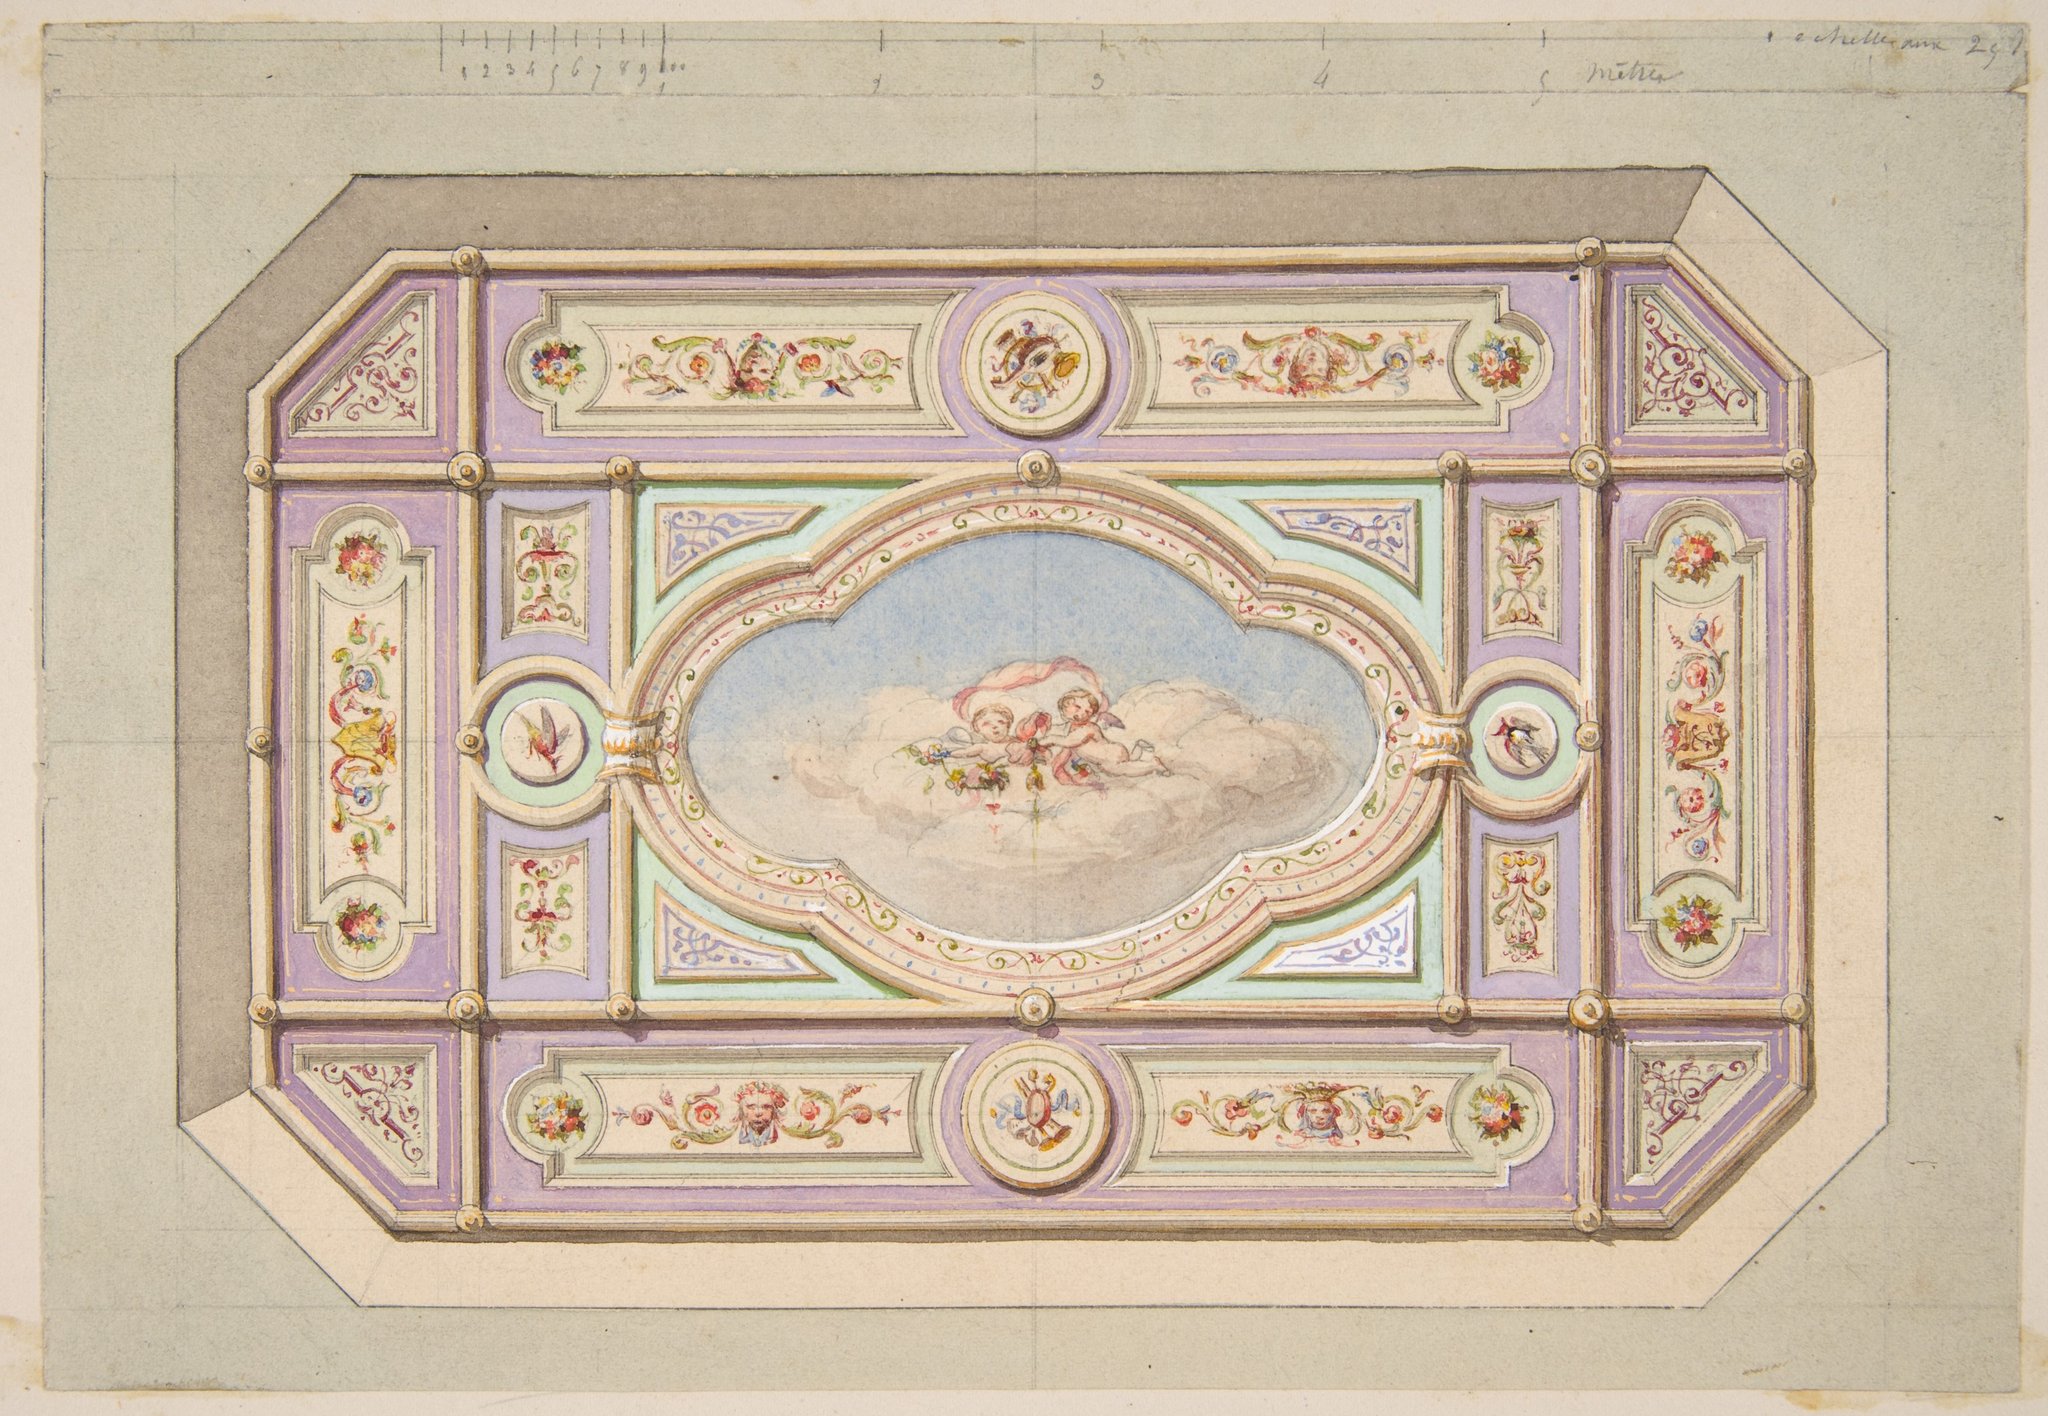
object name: drawing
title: Design for a ceiling with putti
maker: jules-edmond-charles lachaise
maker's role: artist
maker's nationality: french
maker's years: 1897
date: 1851-1900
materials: gouache, graphite, ink, watercolor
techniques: pen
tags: birds,flowers